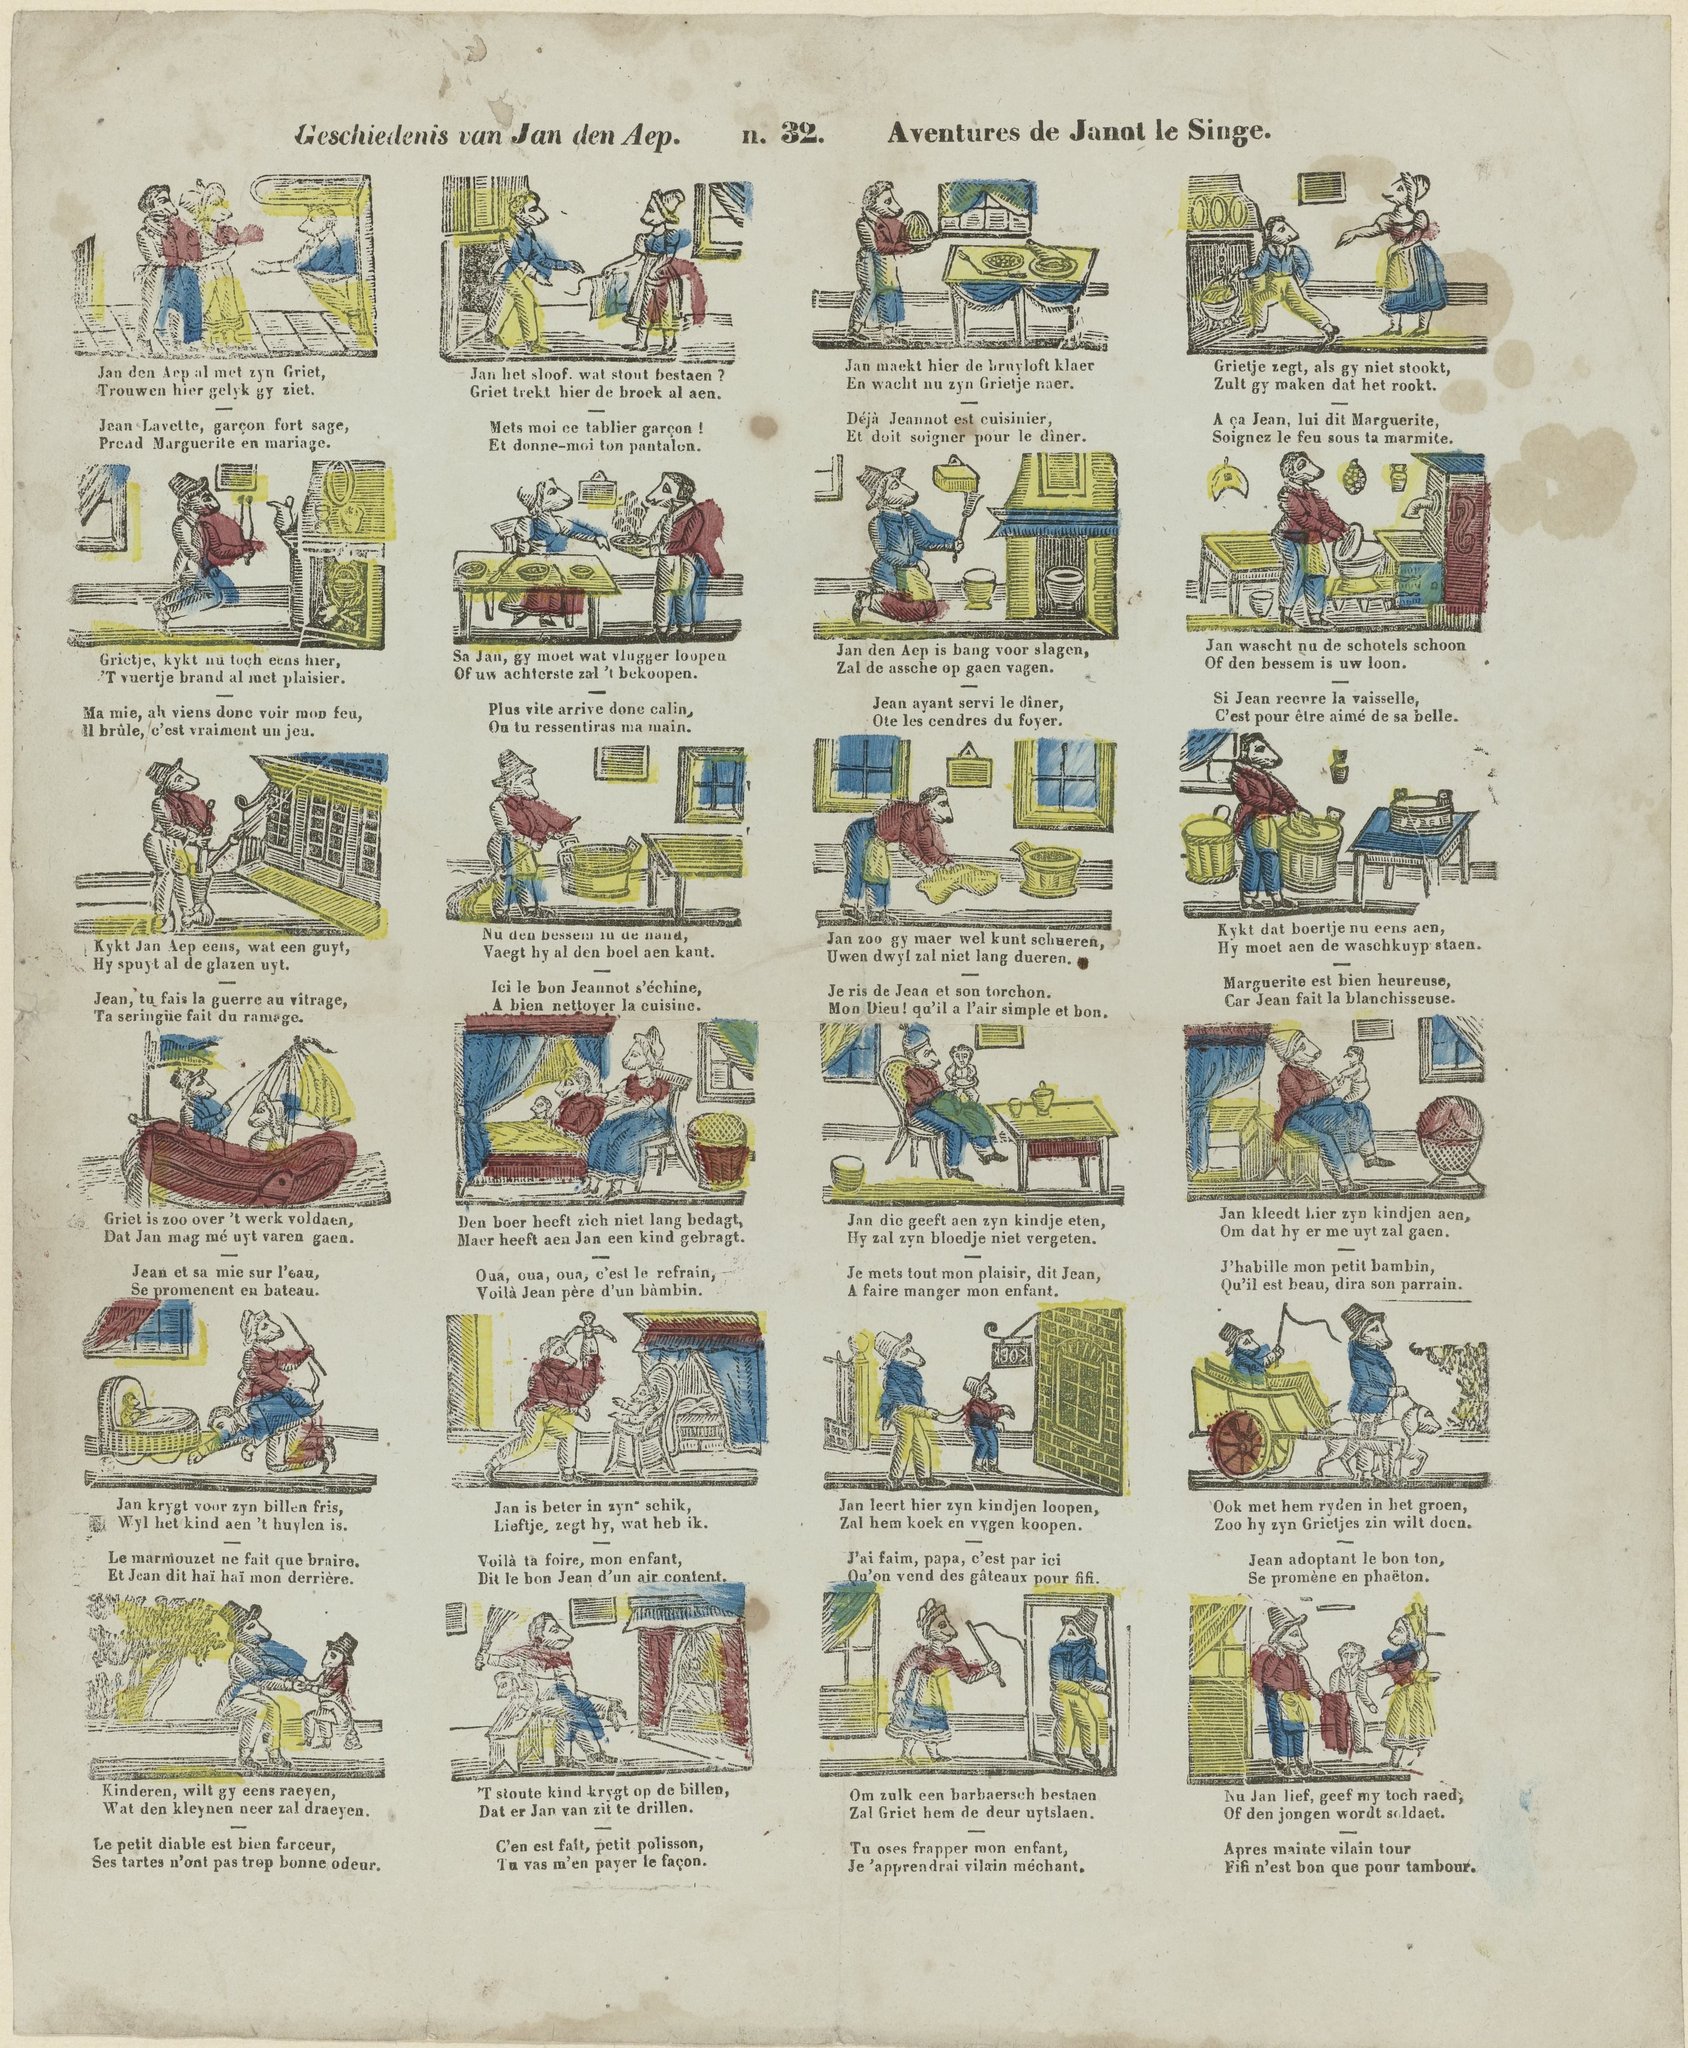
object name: print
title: Geschiedenis van Jan den Aep / Aventures de Janot le Singe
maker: Anonymous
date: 1856-1900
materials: paper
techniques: colour, letterpress printing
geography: turnhout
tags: hen-pecked husband, 'betty', 'molly' (man who engages in women's work), monkeys, apes, animals acting as human beings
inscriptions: collector's mark: Lugt 2760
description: Blad met 24 voorstellingen uit het leven van Jan de Wasser, een man die van zijn vrouw Griet, die de broek aan heeft, al het huishoudelijk werk moet doen. Uitgebeeld met apen in plaats van mensen. Onder elke voorstelling een tweeregelig vers in het Nederlands en in het Frans. Genummerd midden boven: n. 32.